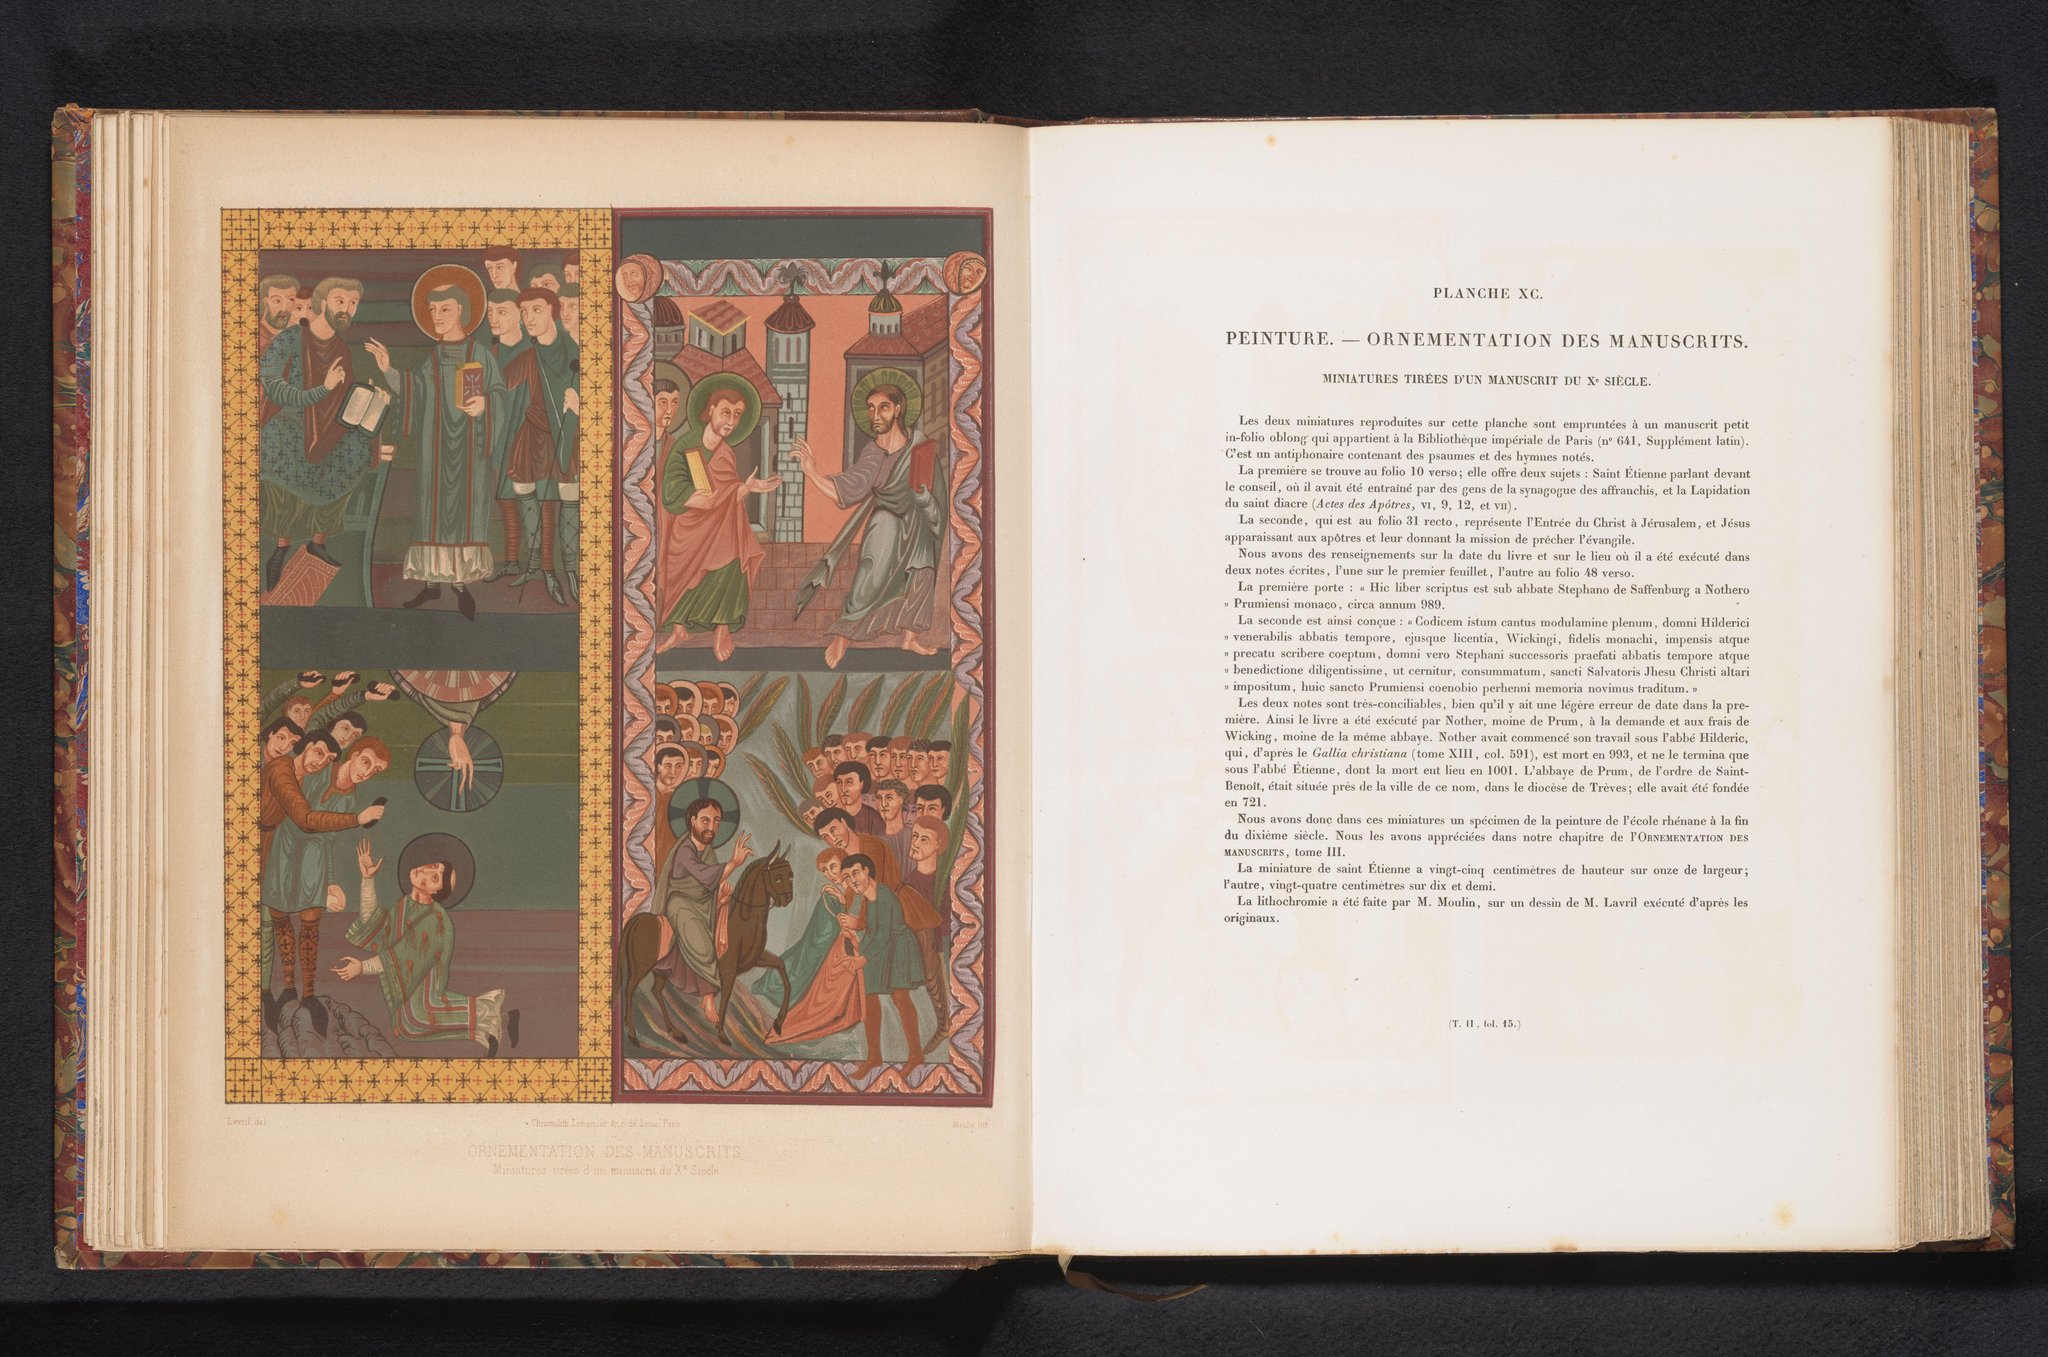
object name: reproduction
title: Reproductie van twee verluchte pagina's met Stefanus en Christus in Jerusalem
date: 1859-1864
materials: paper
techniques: chromolithography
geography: paris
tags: martyrdom and death of stephen, christ as adult, painting (including book-illumination, miniature-painting)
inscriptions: name: ‘Lavril del./ Moulin lith.’